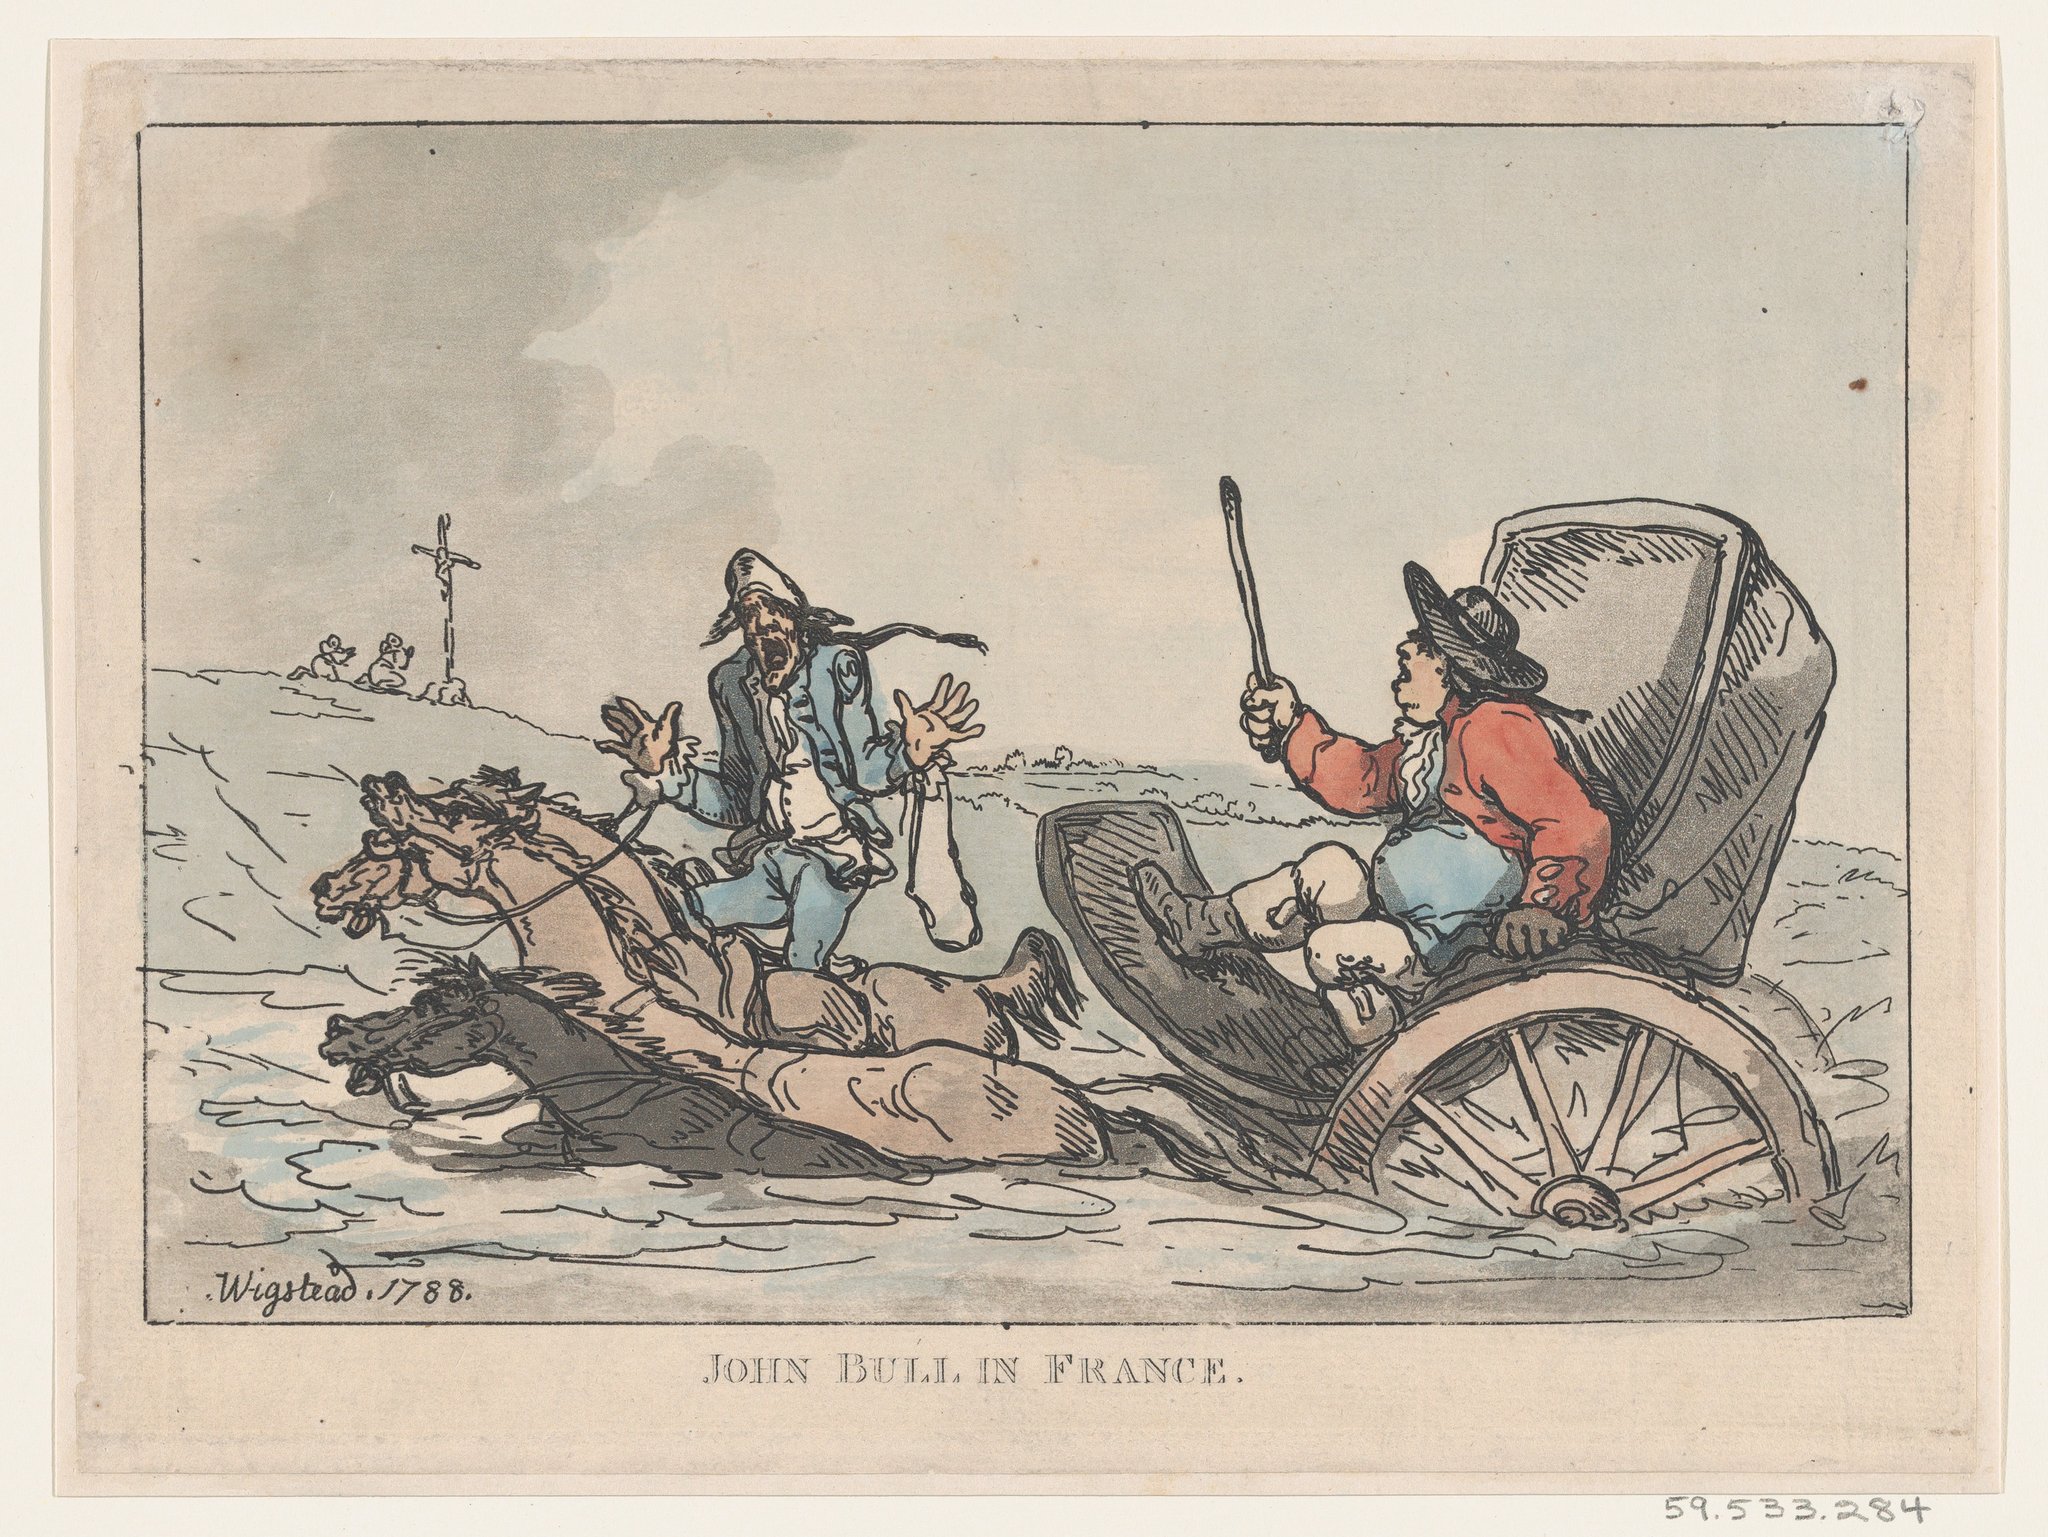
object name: print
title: John Bull in France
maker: thomas rowlandson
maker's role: artist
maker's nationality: british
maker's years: 1757-1827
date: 1788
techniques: aquatint, etching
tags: satire,men,carriages,caricature